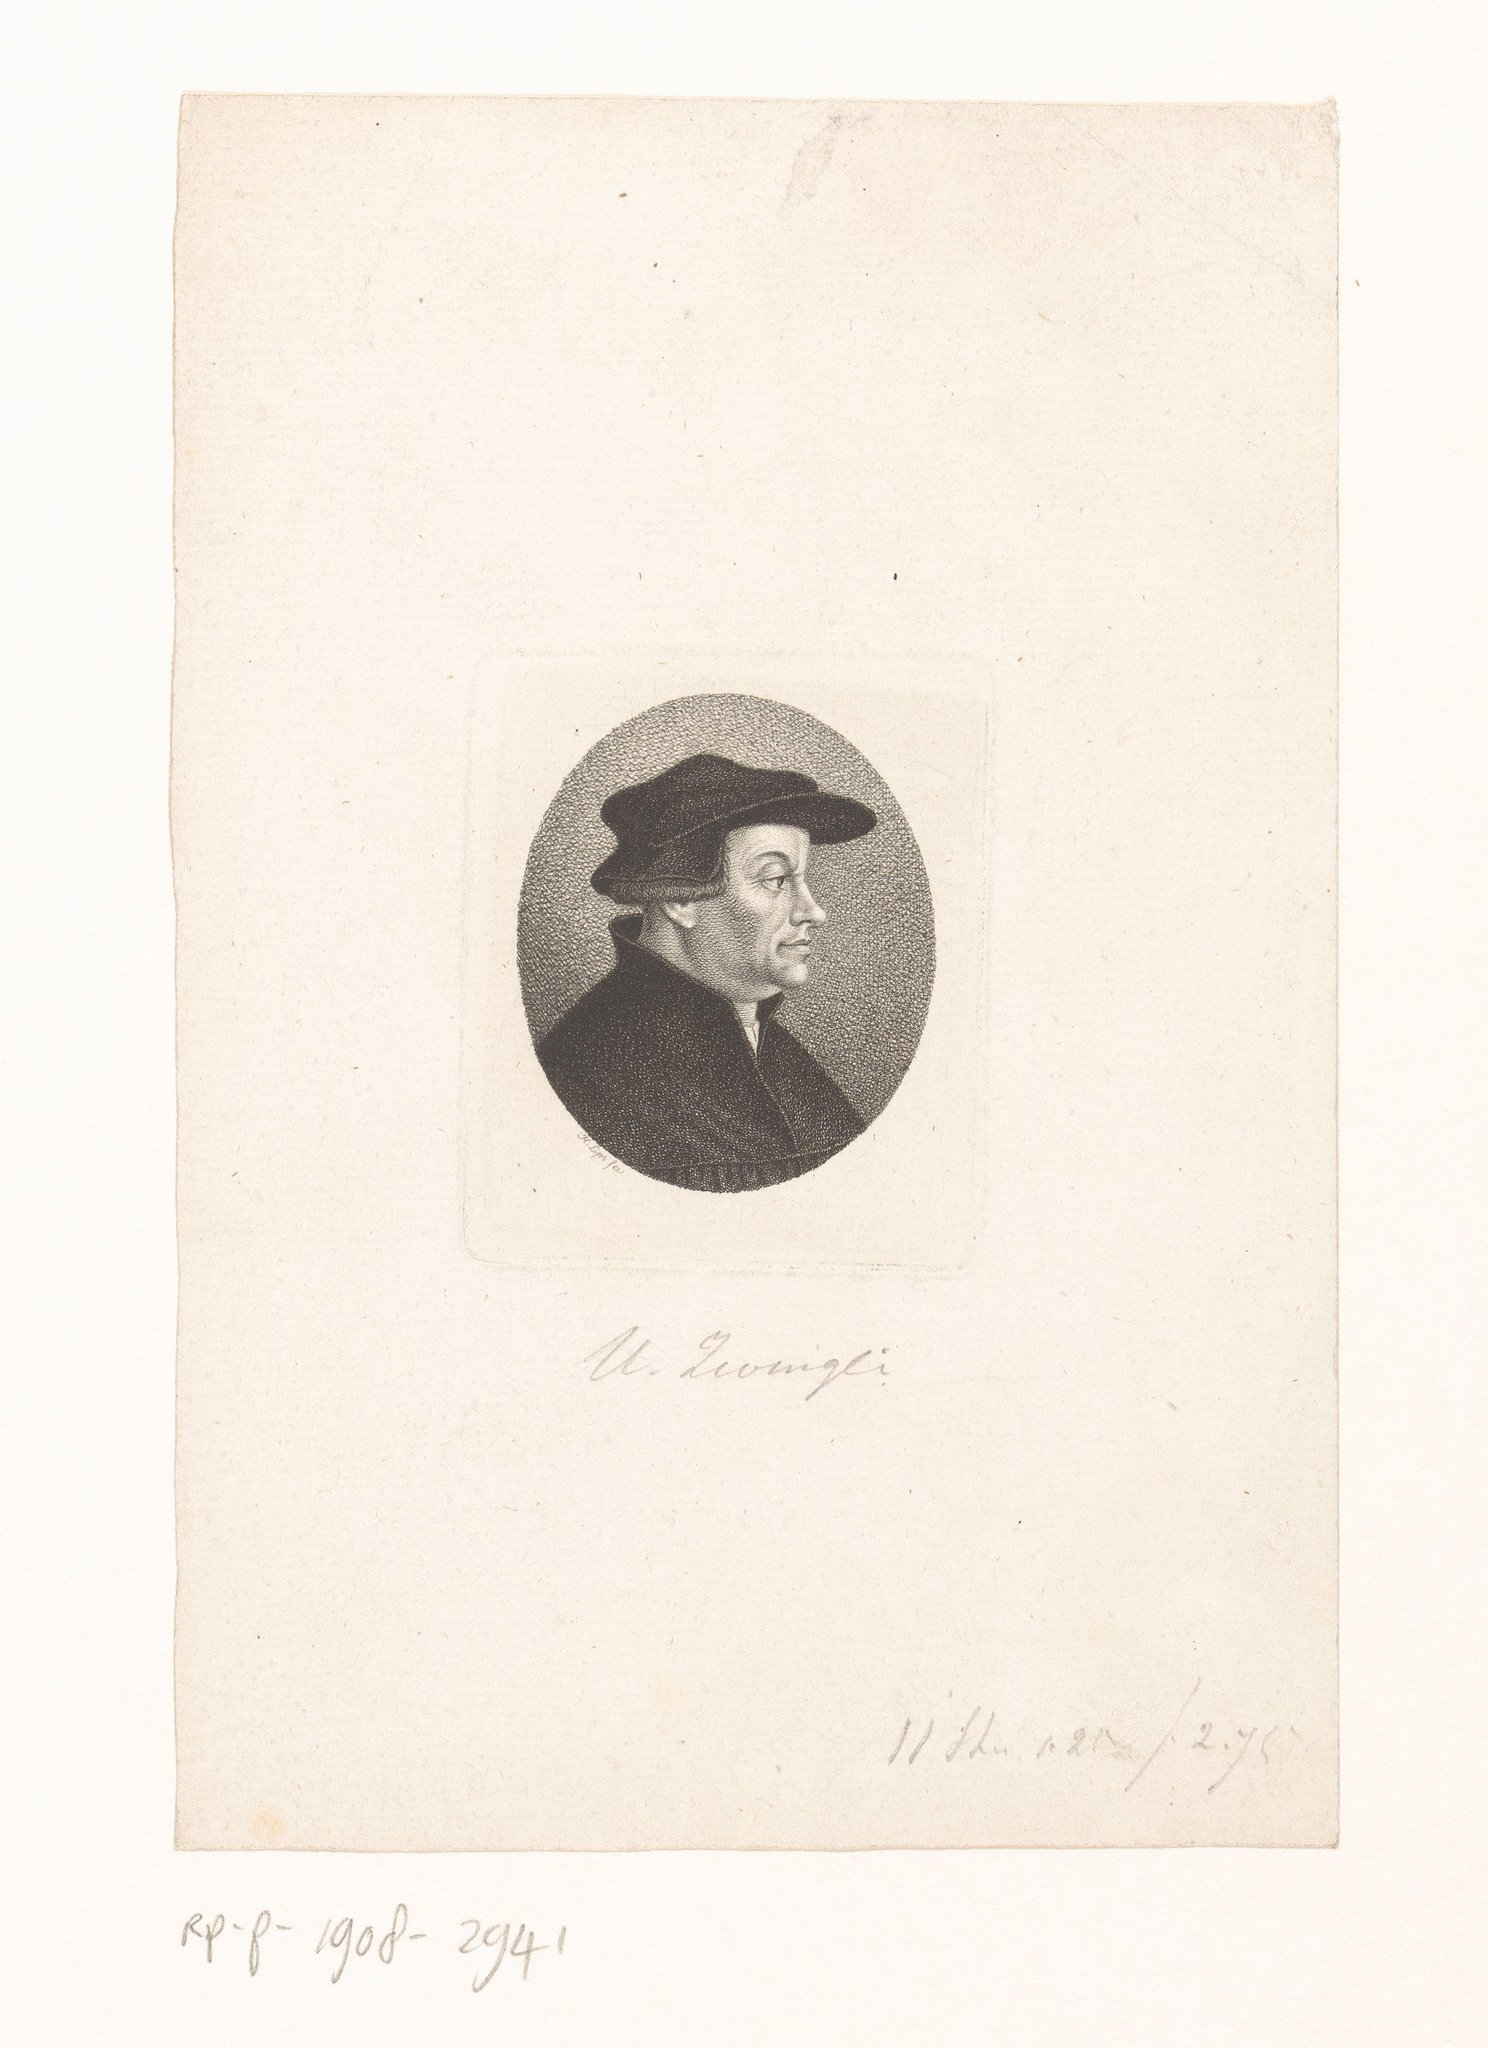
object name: print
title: Portret van Ulrich Zwingli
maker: johann heinrich lips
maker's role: draughtsman, painter, print maker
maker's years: 1758-1817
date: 1768-1817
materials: paper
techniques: stippling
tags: clergyman, theologian, historical persons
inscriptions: collector's mark: Lugt 2228, name